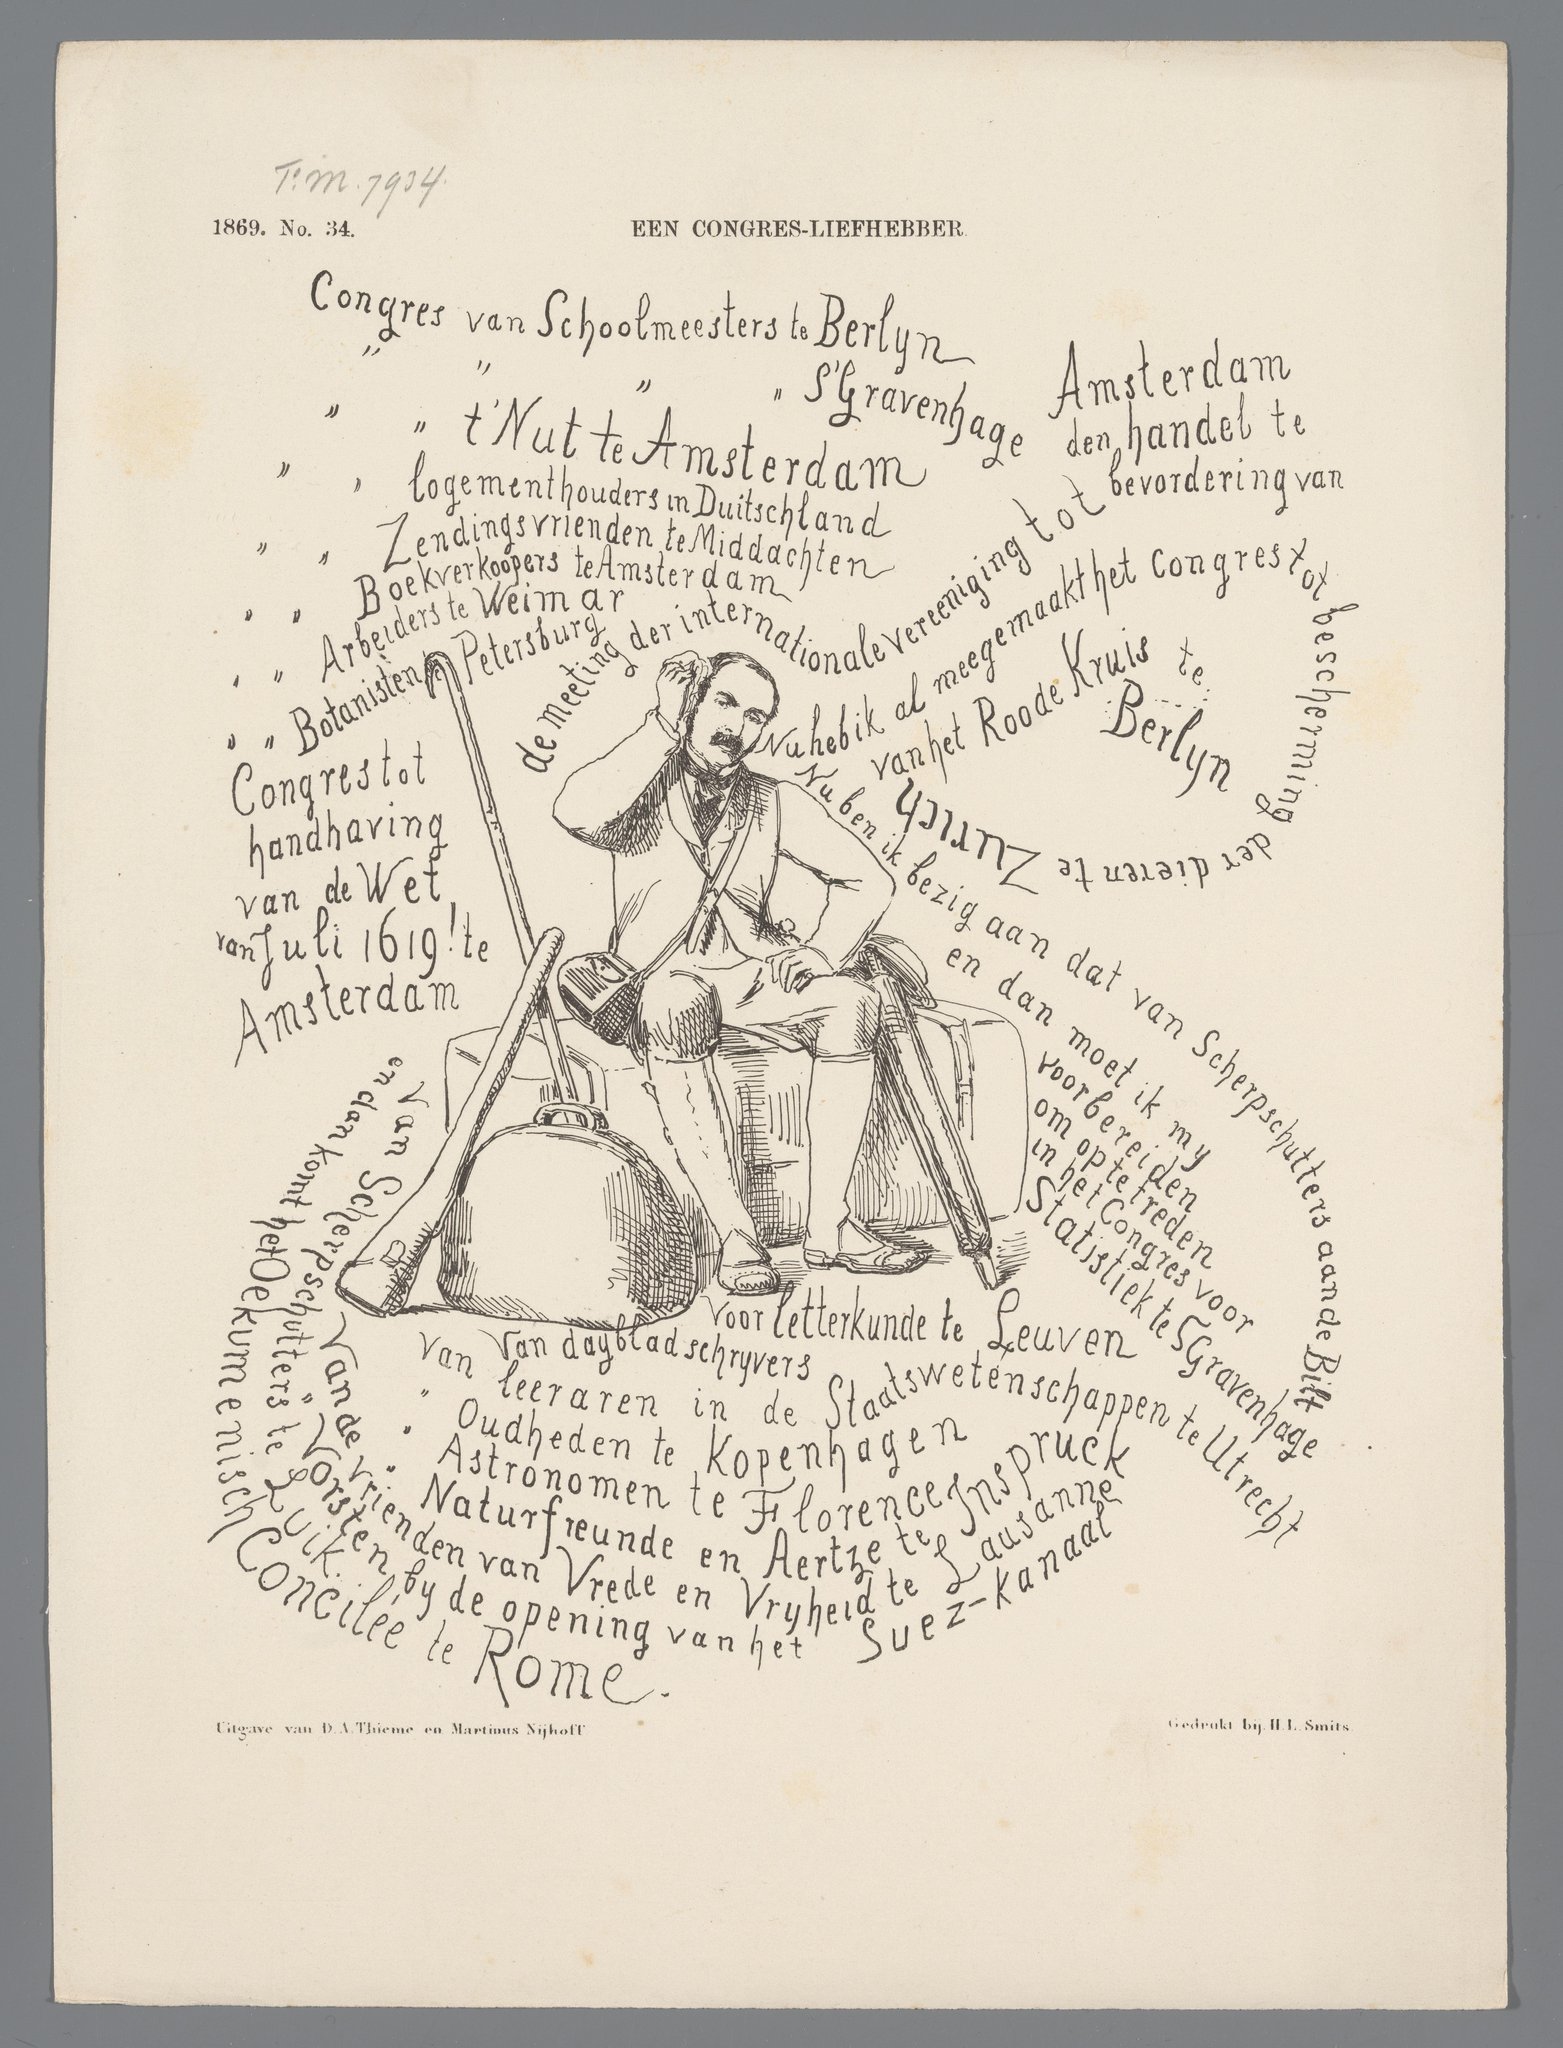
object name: cartoon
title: Een congres-liefhebber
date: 1869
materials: paper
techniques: lithograph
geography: arnhem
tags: meeting, assembly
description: Spotprent op het overvloed aan congressen. Een congresganger zittend op zijn bagage omgeven door de aankondigingen van de vele congressen in binnen- en buitenland. Plaat verschenen bij het weekblad De Nederlandsche Spectator, nr. 34, 1869.